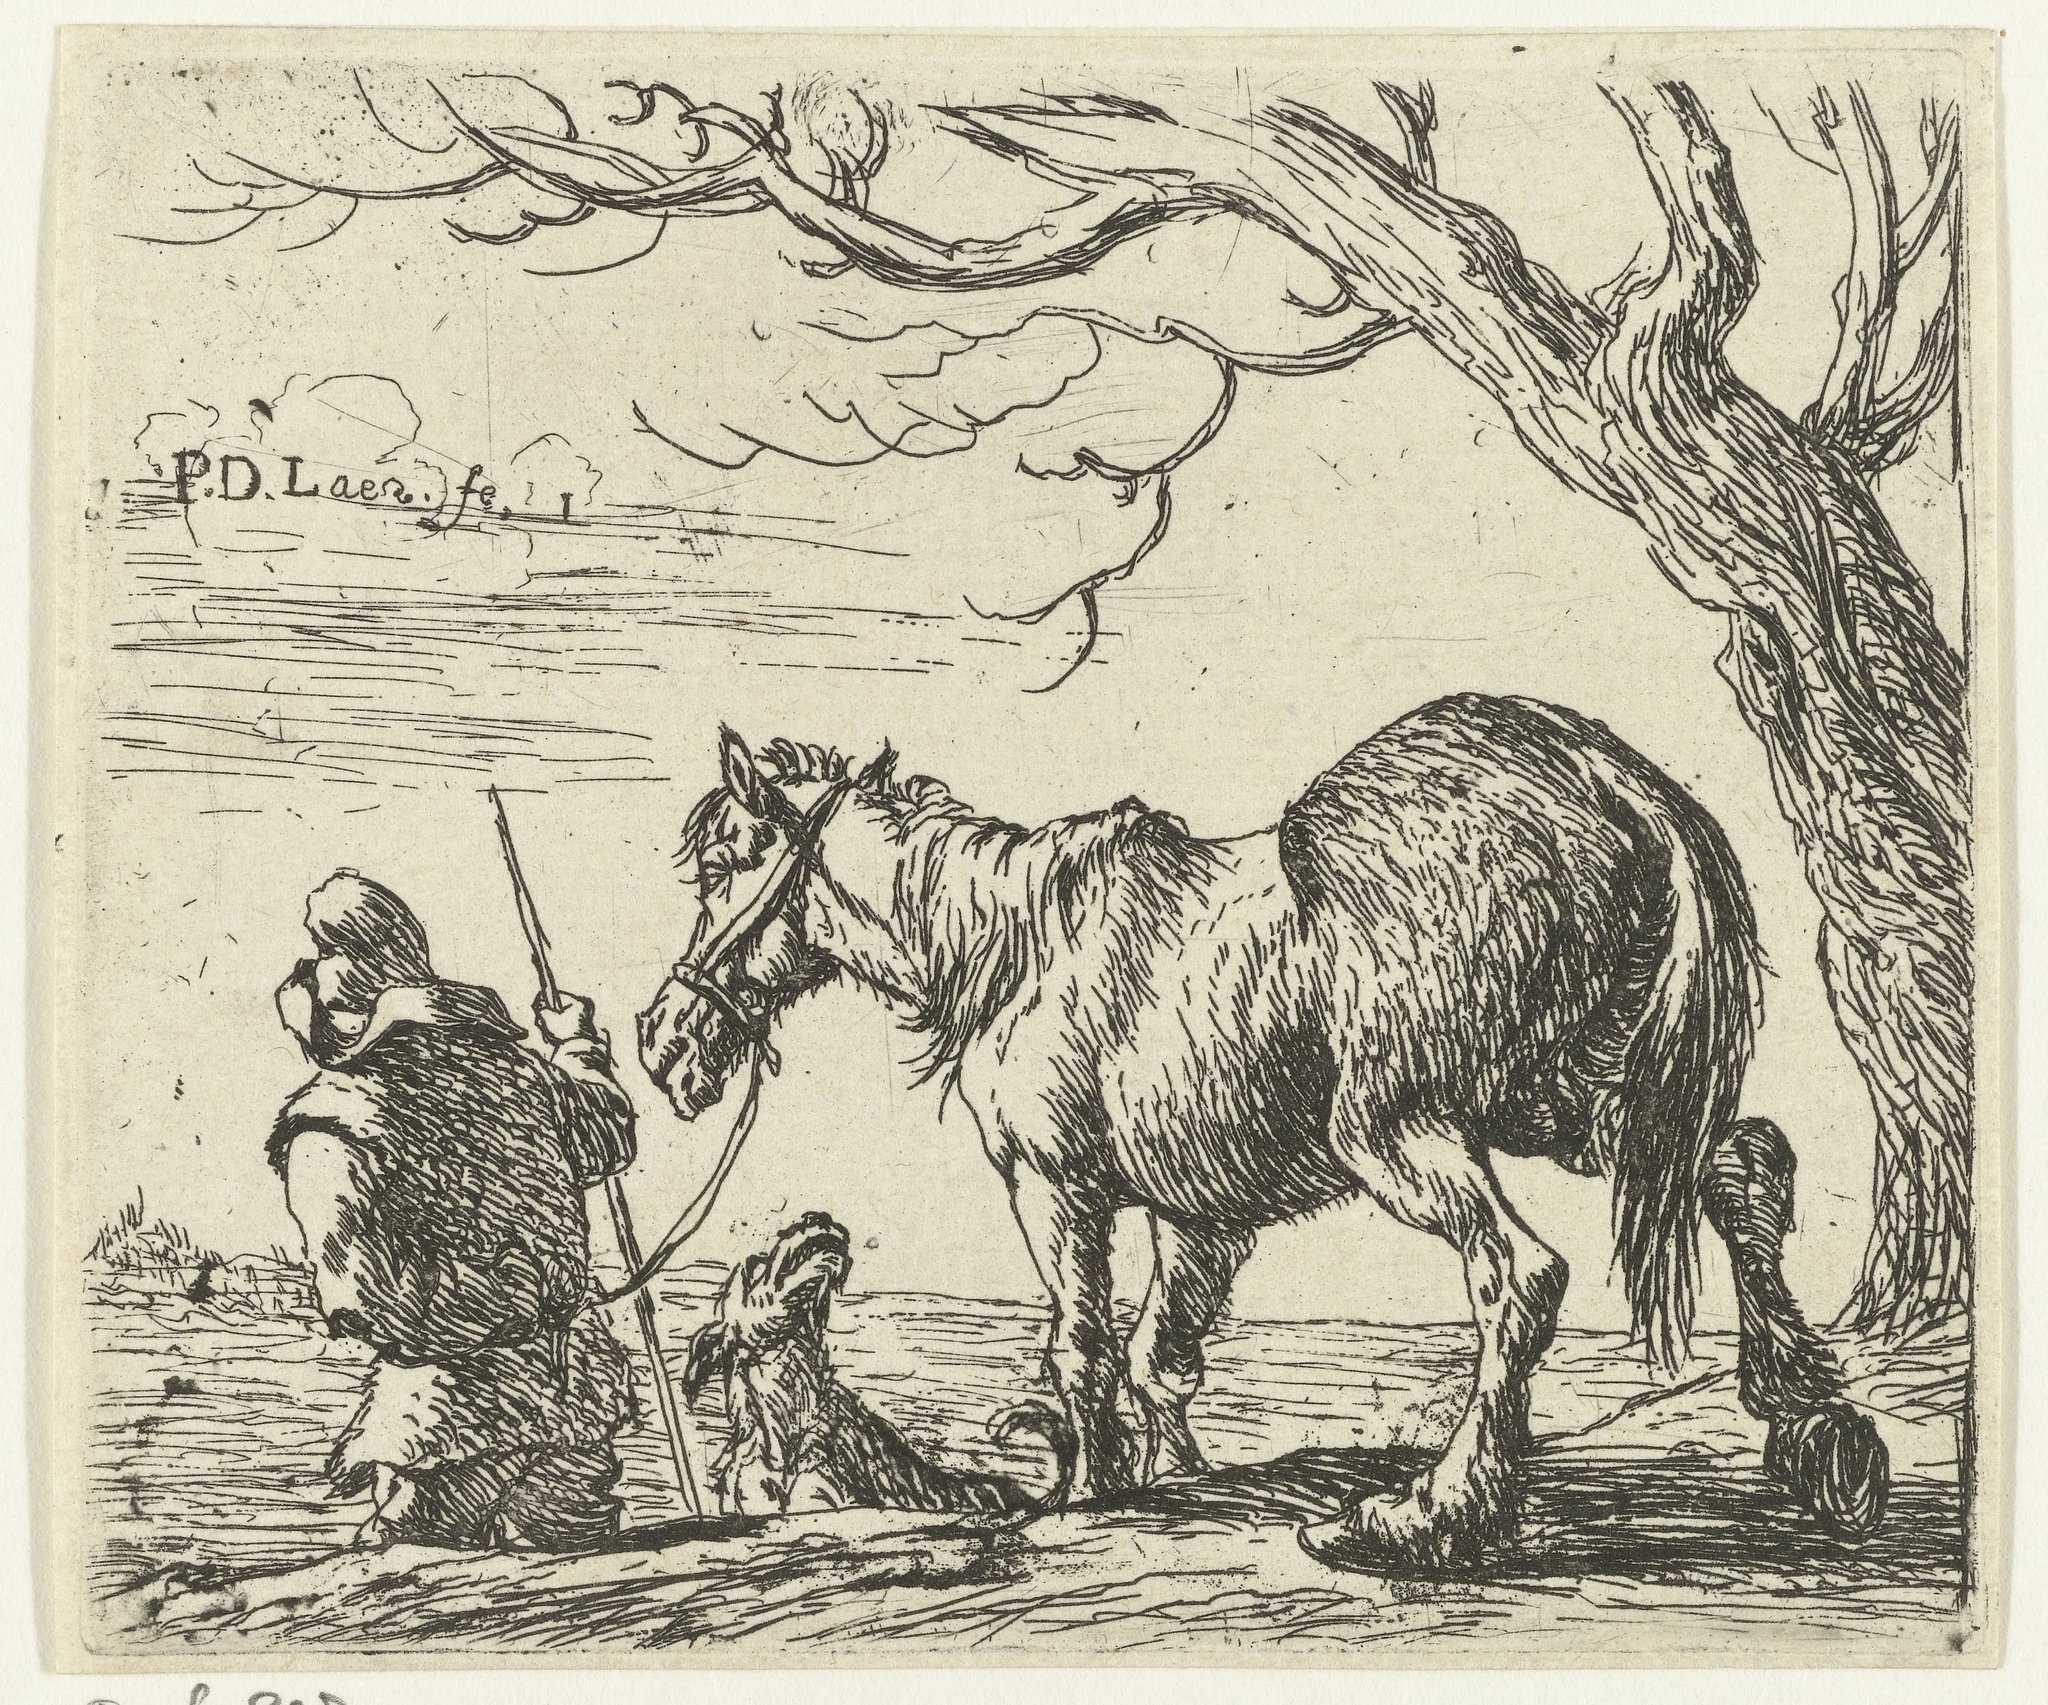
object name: print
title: Paarden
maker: pieter bodding van laer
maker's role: draughtsman, painter, print maker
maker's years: 1599-1642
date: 1609-1642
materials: paper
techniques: etching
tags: farmers, horse, dog (+ audible means of communication of animal(s): roaring, crying, singing, barking, mewing, neighing, chirping, etc.)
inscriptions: collector's mark: Lugt 240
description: Een boer leidt zijn paard, in het midden een blaffende hond. De prent maakt deel uit van een zesdelige serie met voorstellingen van paarden.